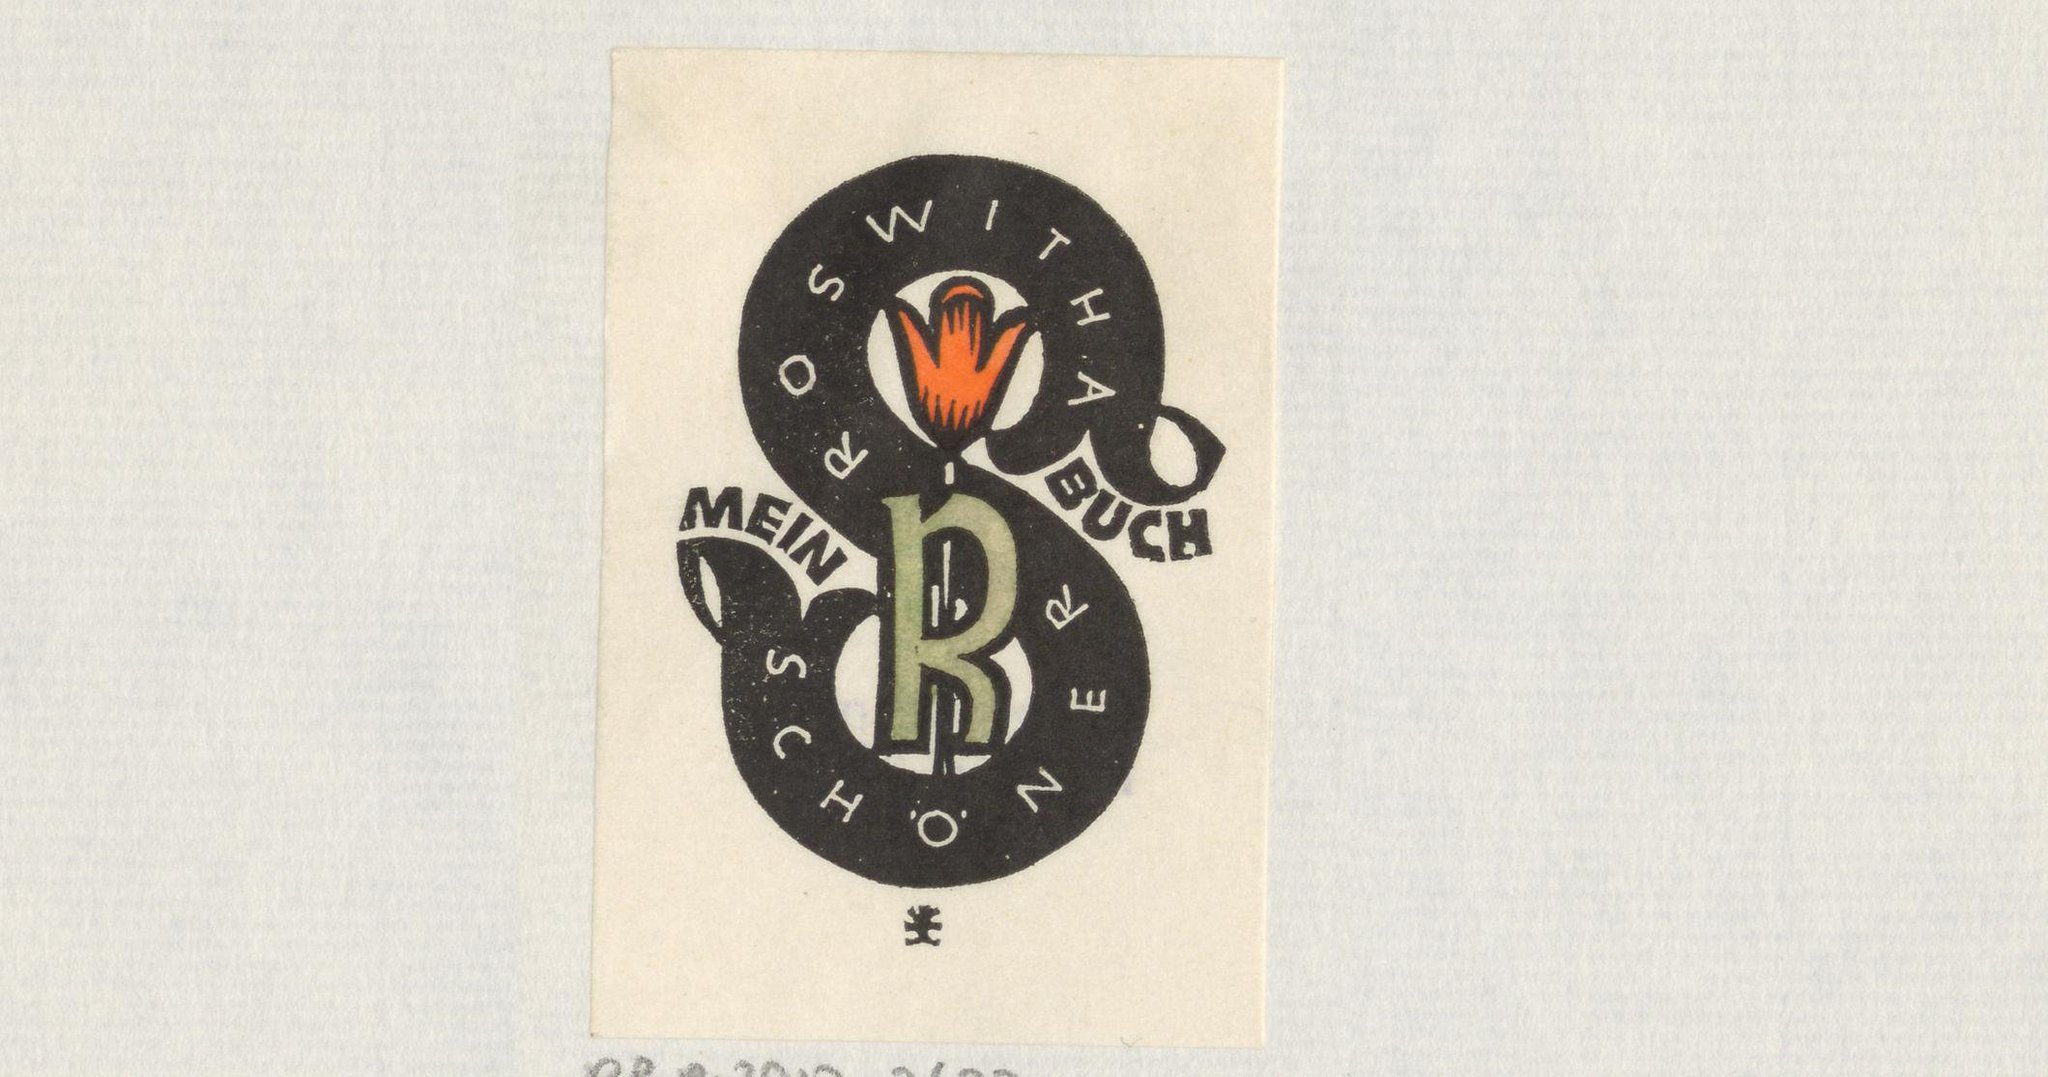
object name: bookplate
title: Mein/ Buch/ Roswitha/ Schöner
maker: karl haselböck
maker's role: print maker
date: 1954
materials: paper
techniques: hand coloring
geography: austria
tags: flowers: tulip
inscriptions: workshop stamp: ‘Holzschnitt/ Haselbock/ 1954’